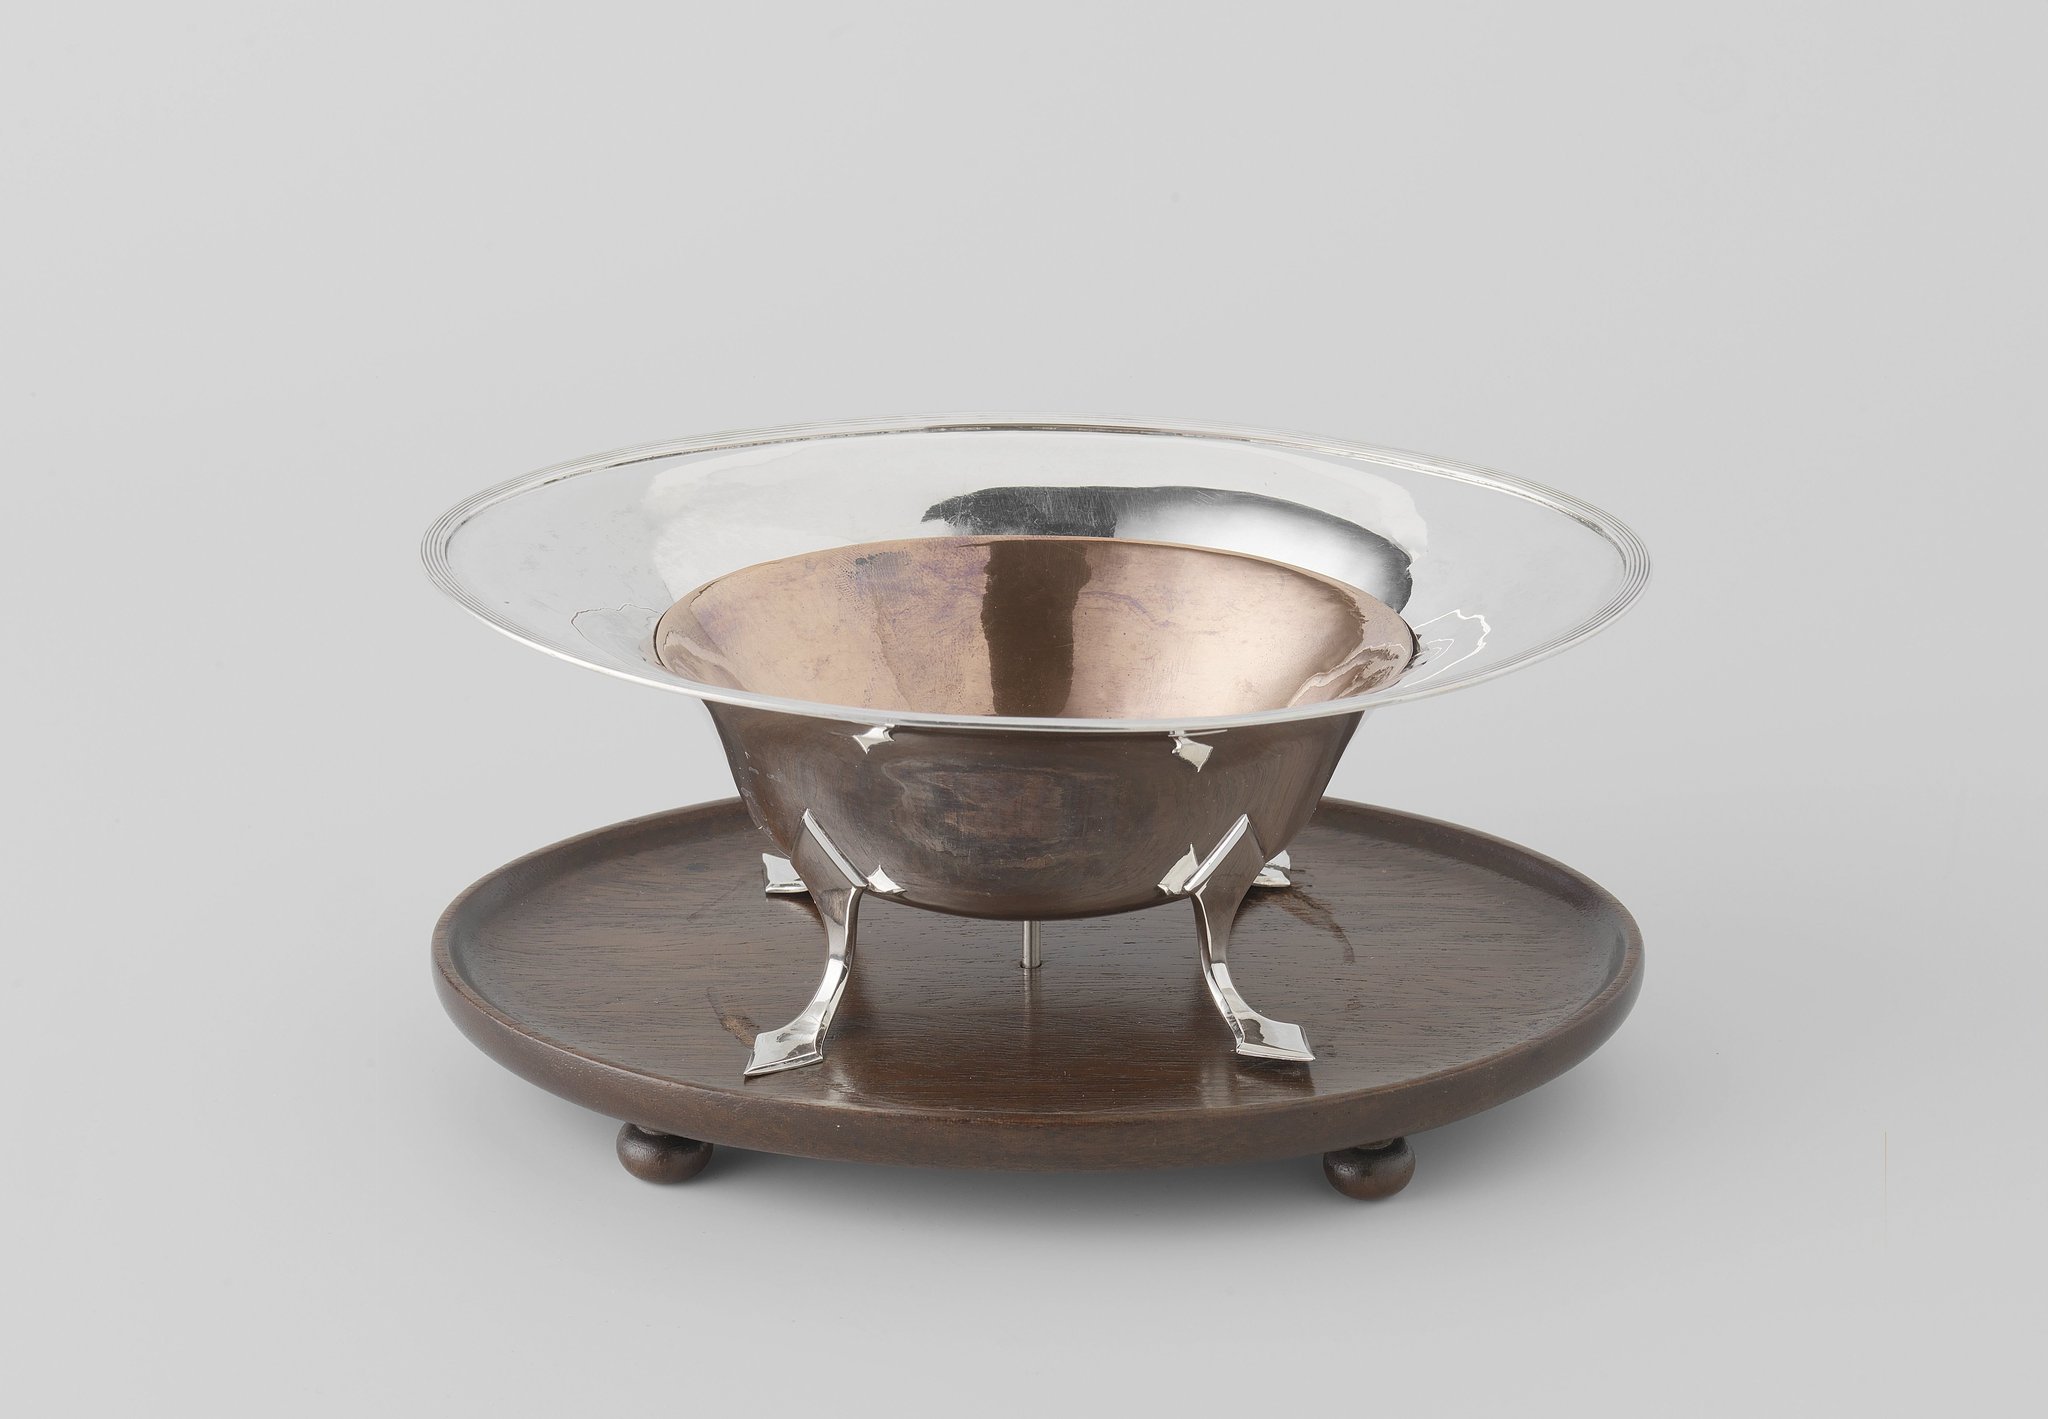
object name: pijpenkomfoor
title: Pijpekomfoor van zilver met vier gebogen poten op blad van mahoniehout. Binnenbak van rood koper. Blad op vier bolpoten.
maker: meinardus warren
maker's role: silversmith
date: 1826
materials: copper, wood, silver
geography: sneek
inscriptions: mark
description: Ovaal pijpekomfoor van zilver met roodkoperen binnenbak, op een mahoniehouten blad. Het komfoor rust op vier gebogen pootjes. Het blad rust op vier gebolde pootjes. De binnenbak, het komfoor en het blad, zijn door een zilveren moer met elkaar verbonden.